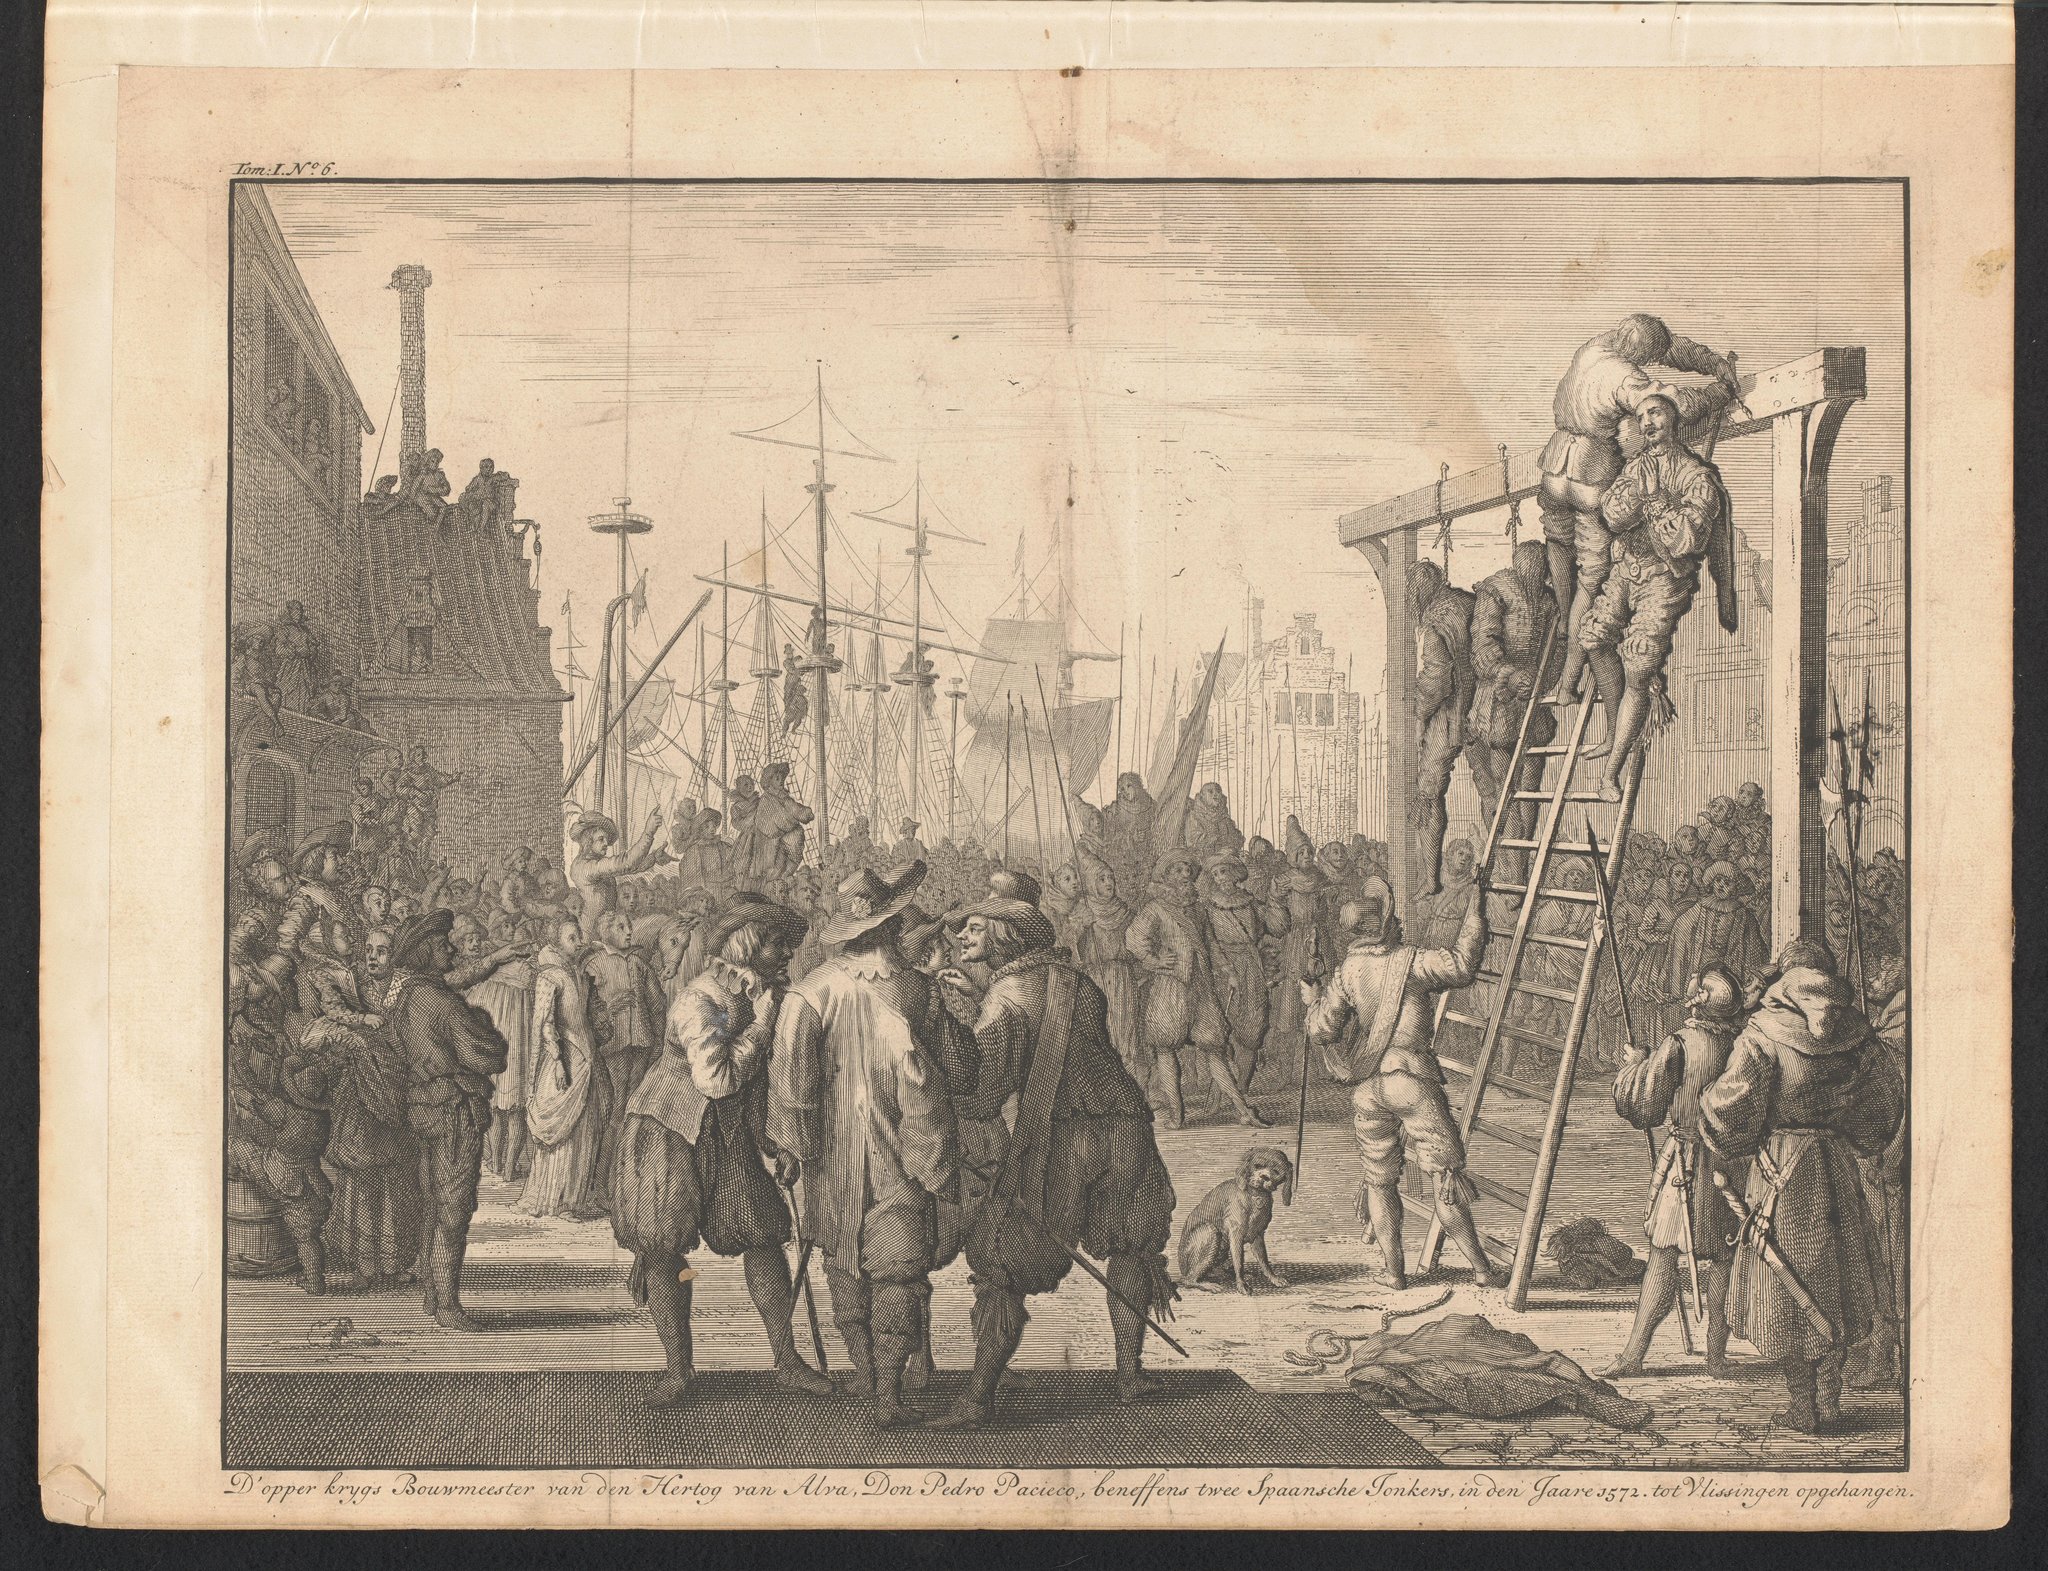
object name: print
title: Pacieco opgehangen te Vlissingen, 1572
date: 1730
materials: paper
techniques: etching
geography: northern netherlands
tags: violent death by hanging, death penalty, execution, flushing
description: Prent waarschijnlijk uit: Le Clerc, Jean. Geschiedenissen der Vereenigde Nederlanden, sedert den aanvang van die Republyk tot op den Vrede van Utrecht in 't jaar 1713 en het Tractaat van Barriere in 't jaar 1715 gesloten. Amsterdam: Zacharias Chatelain, 1730, dl. 1, p. 35-36. Eerdere staat gebruikt in: Bor, Pieter Christiaensz. Oorsprongk, begin, en vervolgh der Nederlandsche Oorlogen (...), Amsterdam: weduwe van Joannes van Someren, Abraham Wolfgangh, Hendrick en Dirk Boom, 1681, dl. 1 (1679), p. 370. Eerdere staat ook gebruikt in: Hooft, Pieter Corneliszoon. Nederlandsche historien; Seedert de Ooverdraght der Heerschappye van Kaizar Karel den Vyfden op Koning Philips zynen Zoon (...). Amsterdam: Henrik Wetstein en Peter Sceperus, 1703, dl. 1, p. 236-237.